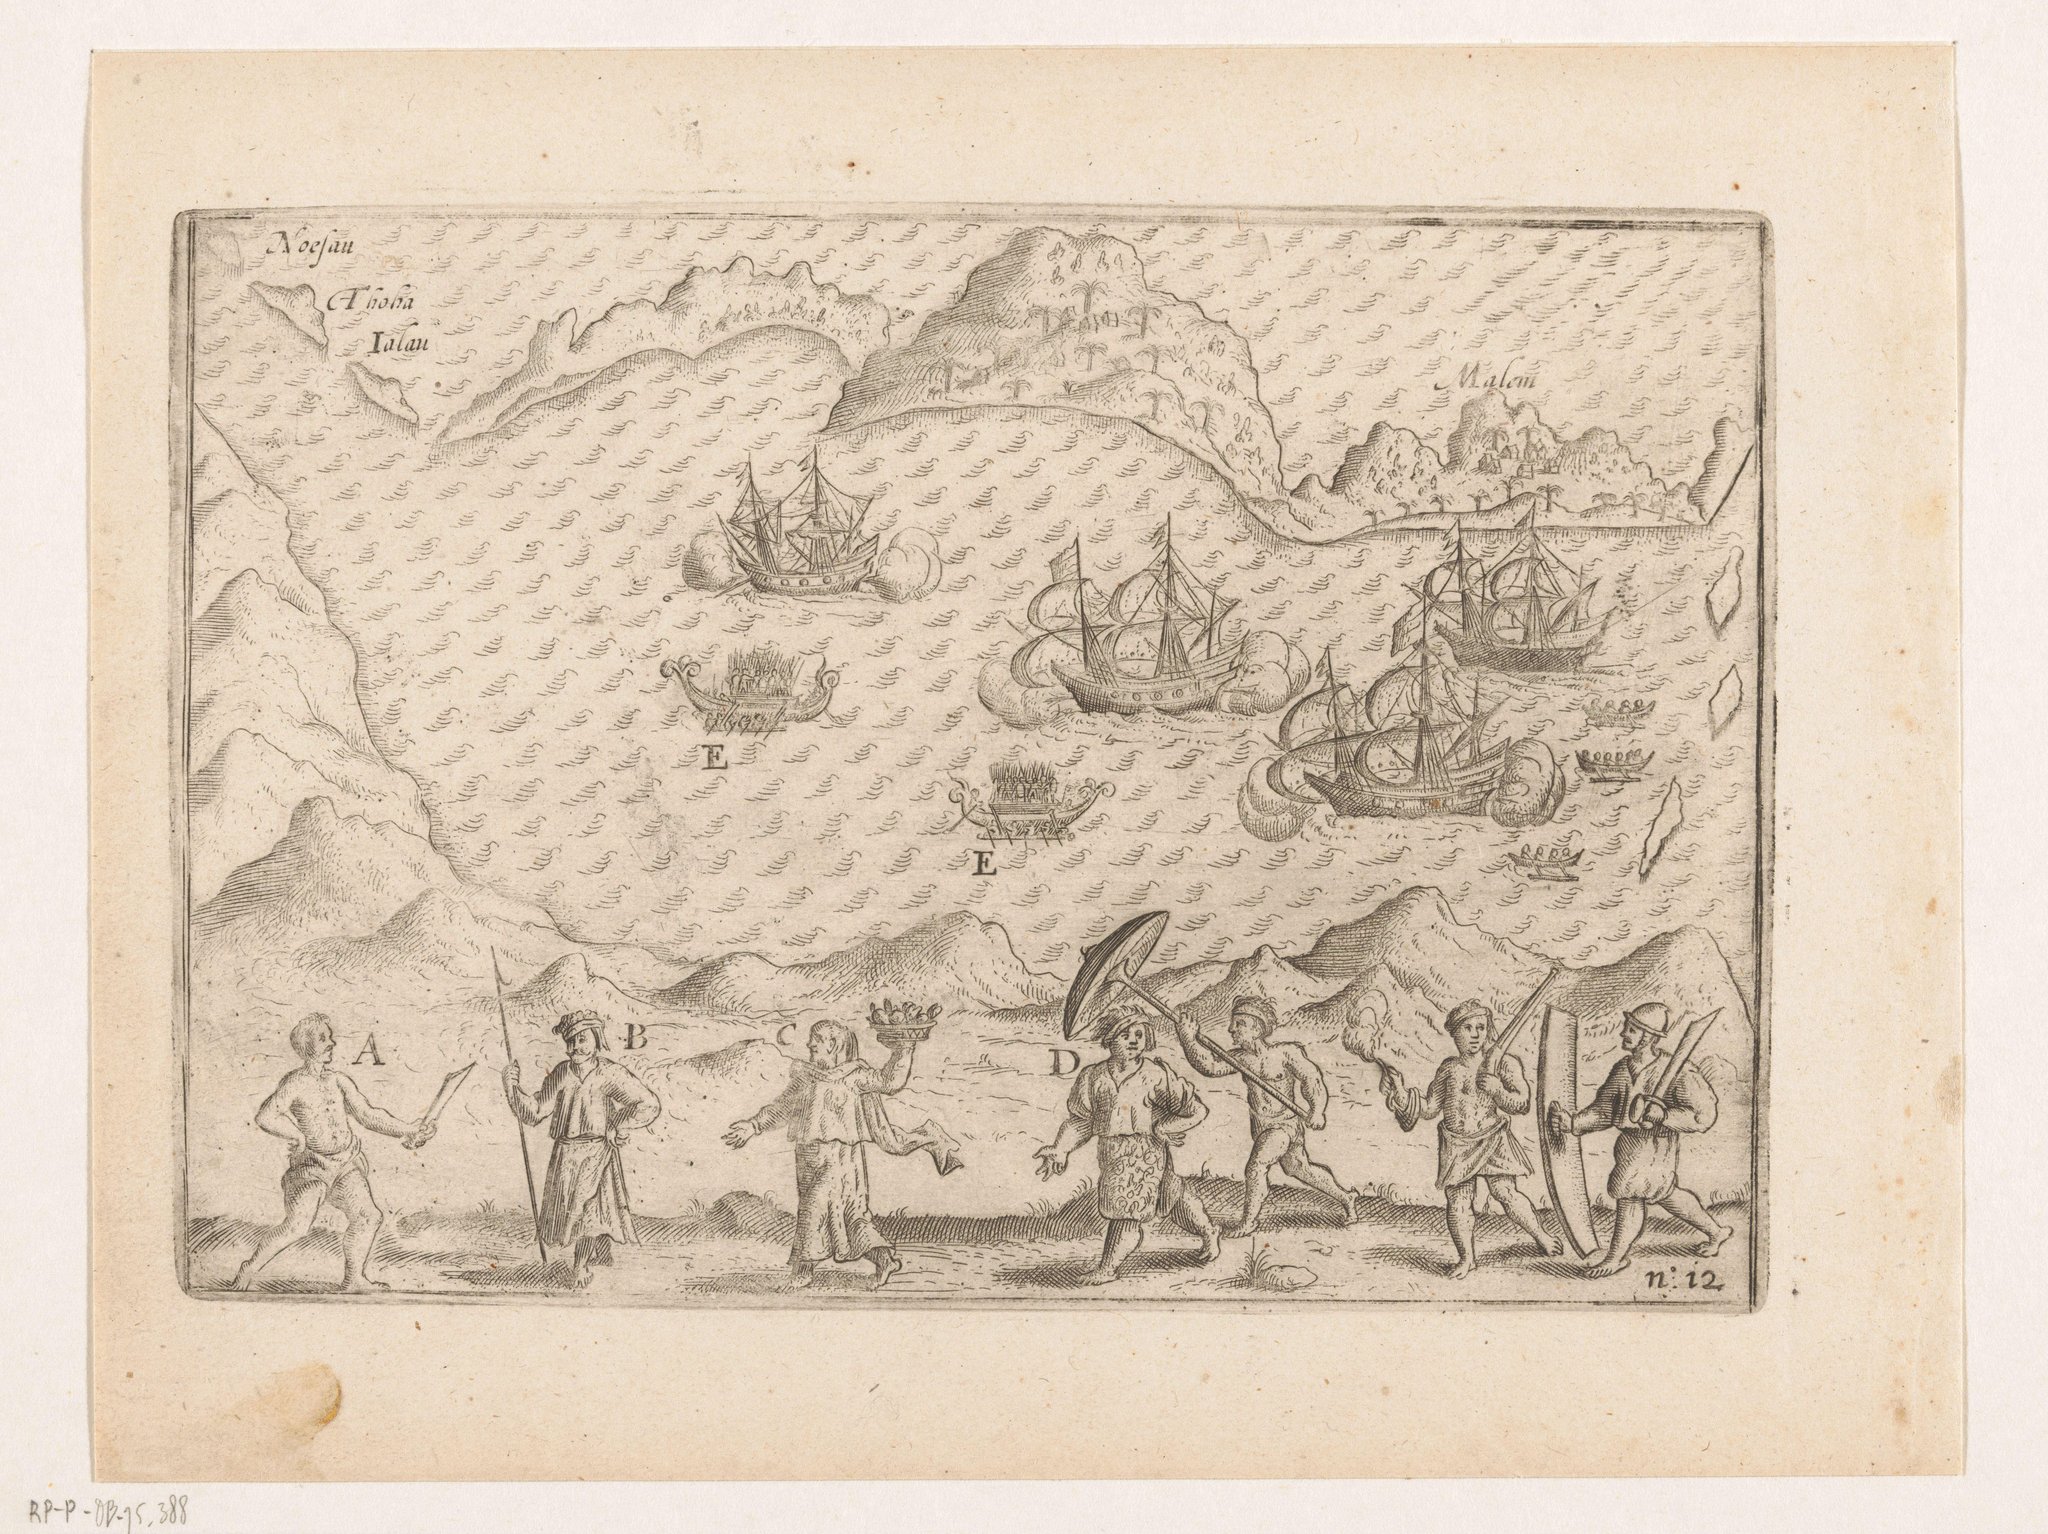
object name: print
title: Ambon en enkele van haar inwoners, 1599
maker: Anonymous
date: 1600-1601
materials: paper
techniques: engraving, etching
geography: northern netherlands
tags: mayor, amsterdam, landscapes in tropical and sub-tropical regions, exploration, expedition, voyage of discovery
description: Gebruikt als illustratie eerst in: Journael ofte Dagh-register, inhoudende een waerachtigh verhael ... vande reyse, ghedaen door de acht schepen van Amsterdamme, onde 'tbeleydt van Iacob Cornelisz. Neck. als Admirael, ende VVybrandt van VVarvvijck, als Vice-admirael, van Amsterdam gheseylt inden jare 1598, Cornelis Claes, Amsterdam [1600], plaat No. 5. In deze staat gebruikt in: Oost-Indische ende West-Indische voyagien, Michiel Colijn, Amsterdam 1619 en later in: Waerachtigh verhael van de Schipvaerd op Oost-Indien ghedaen by de acht Schepen in den jare 1598 van Amsterdam uyt-ghezeylt, onder 't beleyd van den Admirael Jacob Cornelissoon van Neck, ende Vice-Admirael Wybrand van Warwijck. Opgenomen in: I. Commelin, Begin ende voortgangh, van de Vereenighde Nederlantsche Geoctroyeerde Oost-Indische Compagnie, J. Janssonius, Amsterdam 1646. Genummerd: 12.